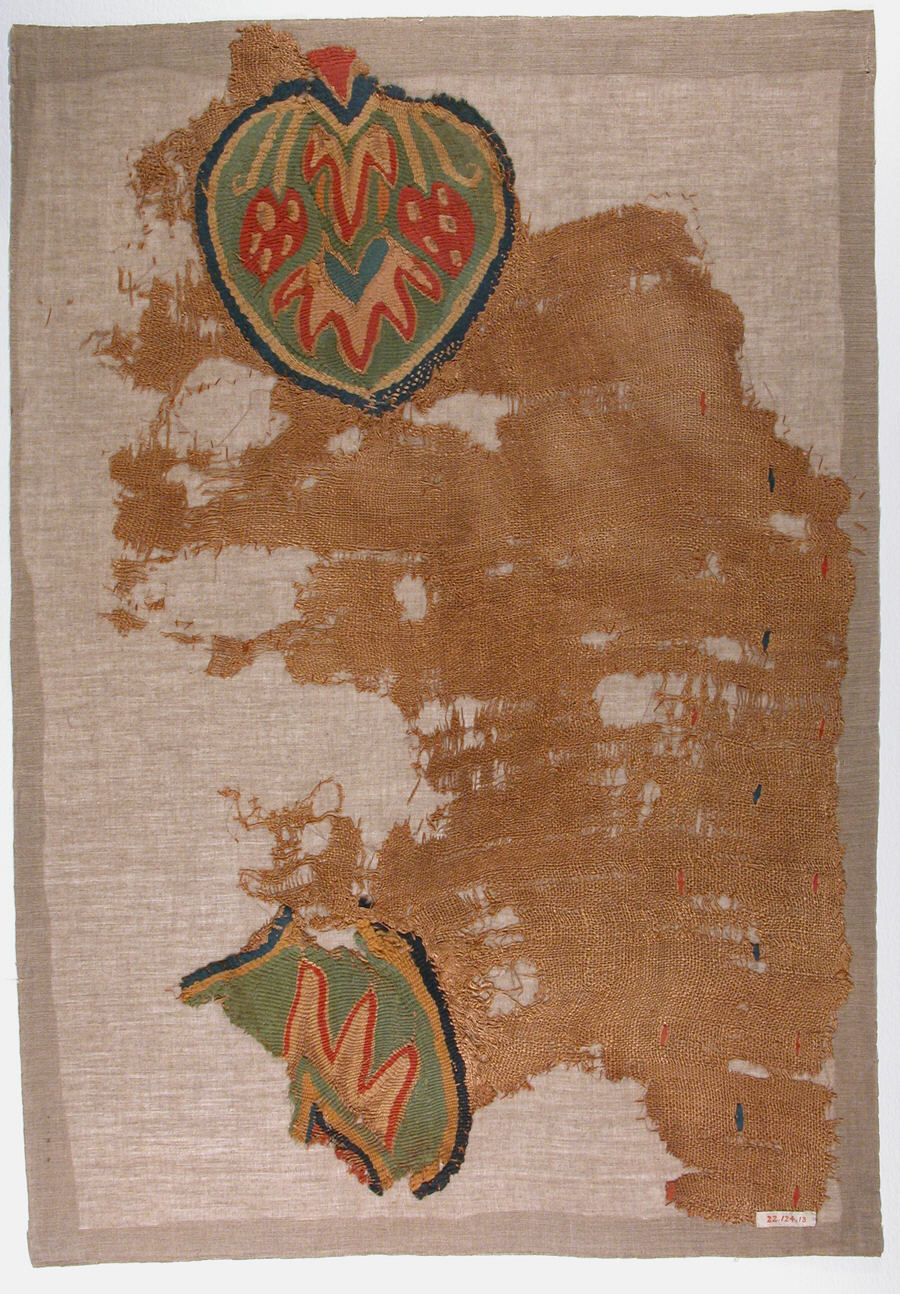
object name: fragment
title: Textile Fragment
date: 301-600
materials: linen, wool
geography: egypt